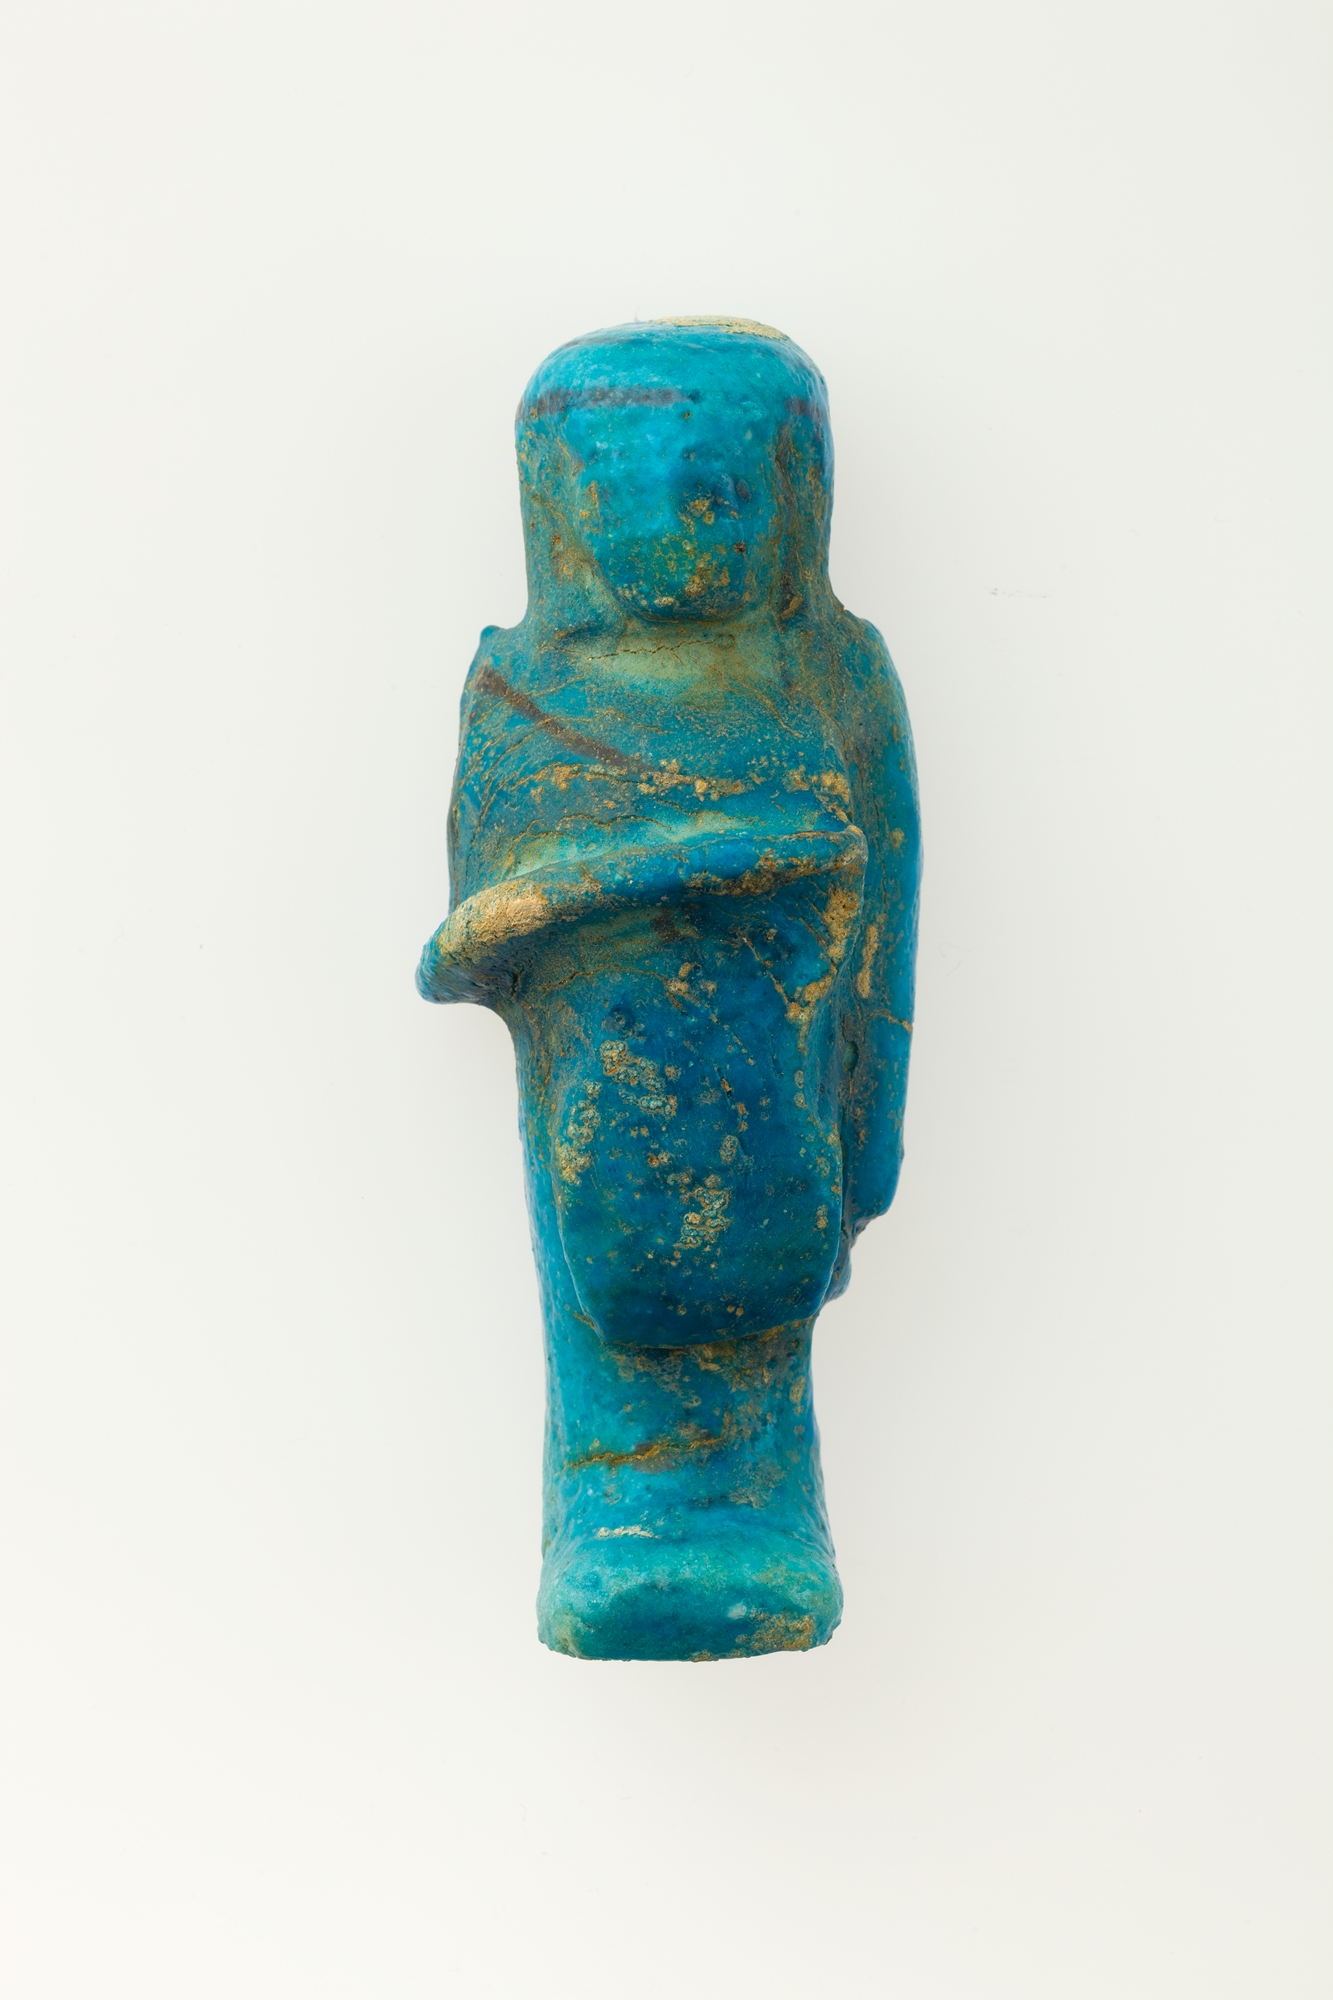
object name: shabti, henettawy c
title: Overseer Shabti of Henettawy (C), Daughter of Isetemkheb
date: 990-970 BCE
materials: faience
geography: egypt